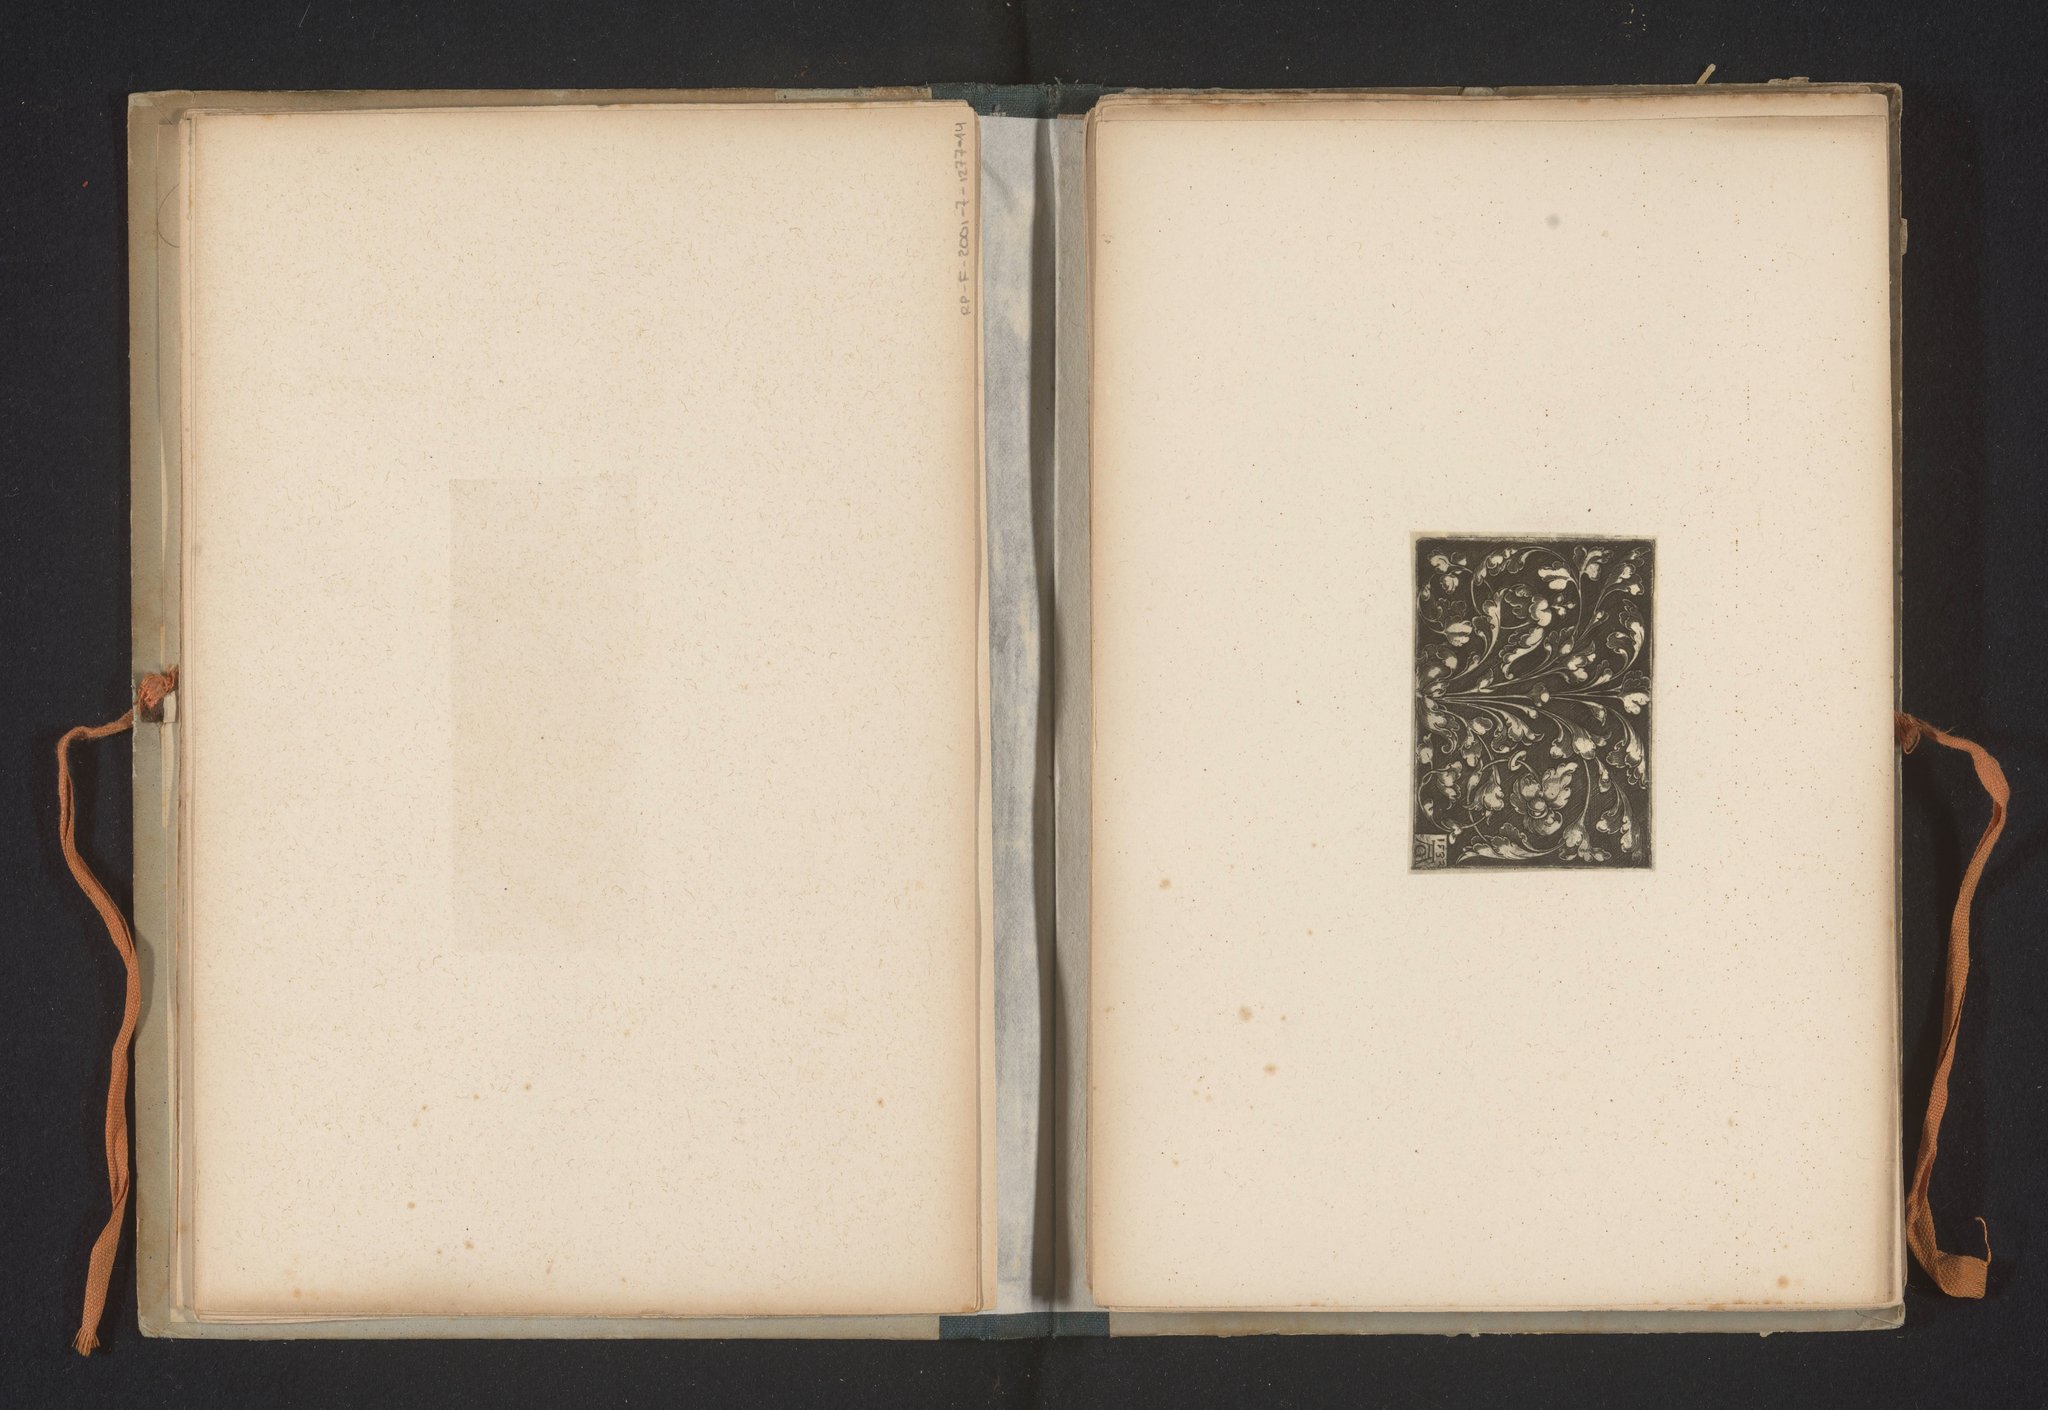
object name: photomechanical print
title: Reproductie van een prent van bladranken door Heinrich Aldegrever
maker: heinrich aldegrever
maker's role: draughtsman, print maker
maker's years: 1502-1561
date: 1866-1871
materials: paper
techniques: woodburytype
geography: brussels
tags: tendrils ~ ornament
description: Deze prent maakt deel uit van een omslag met 57 prenten op 54 bladen.